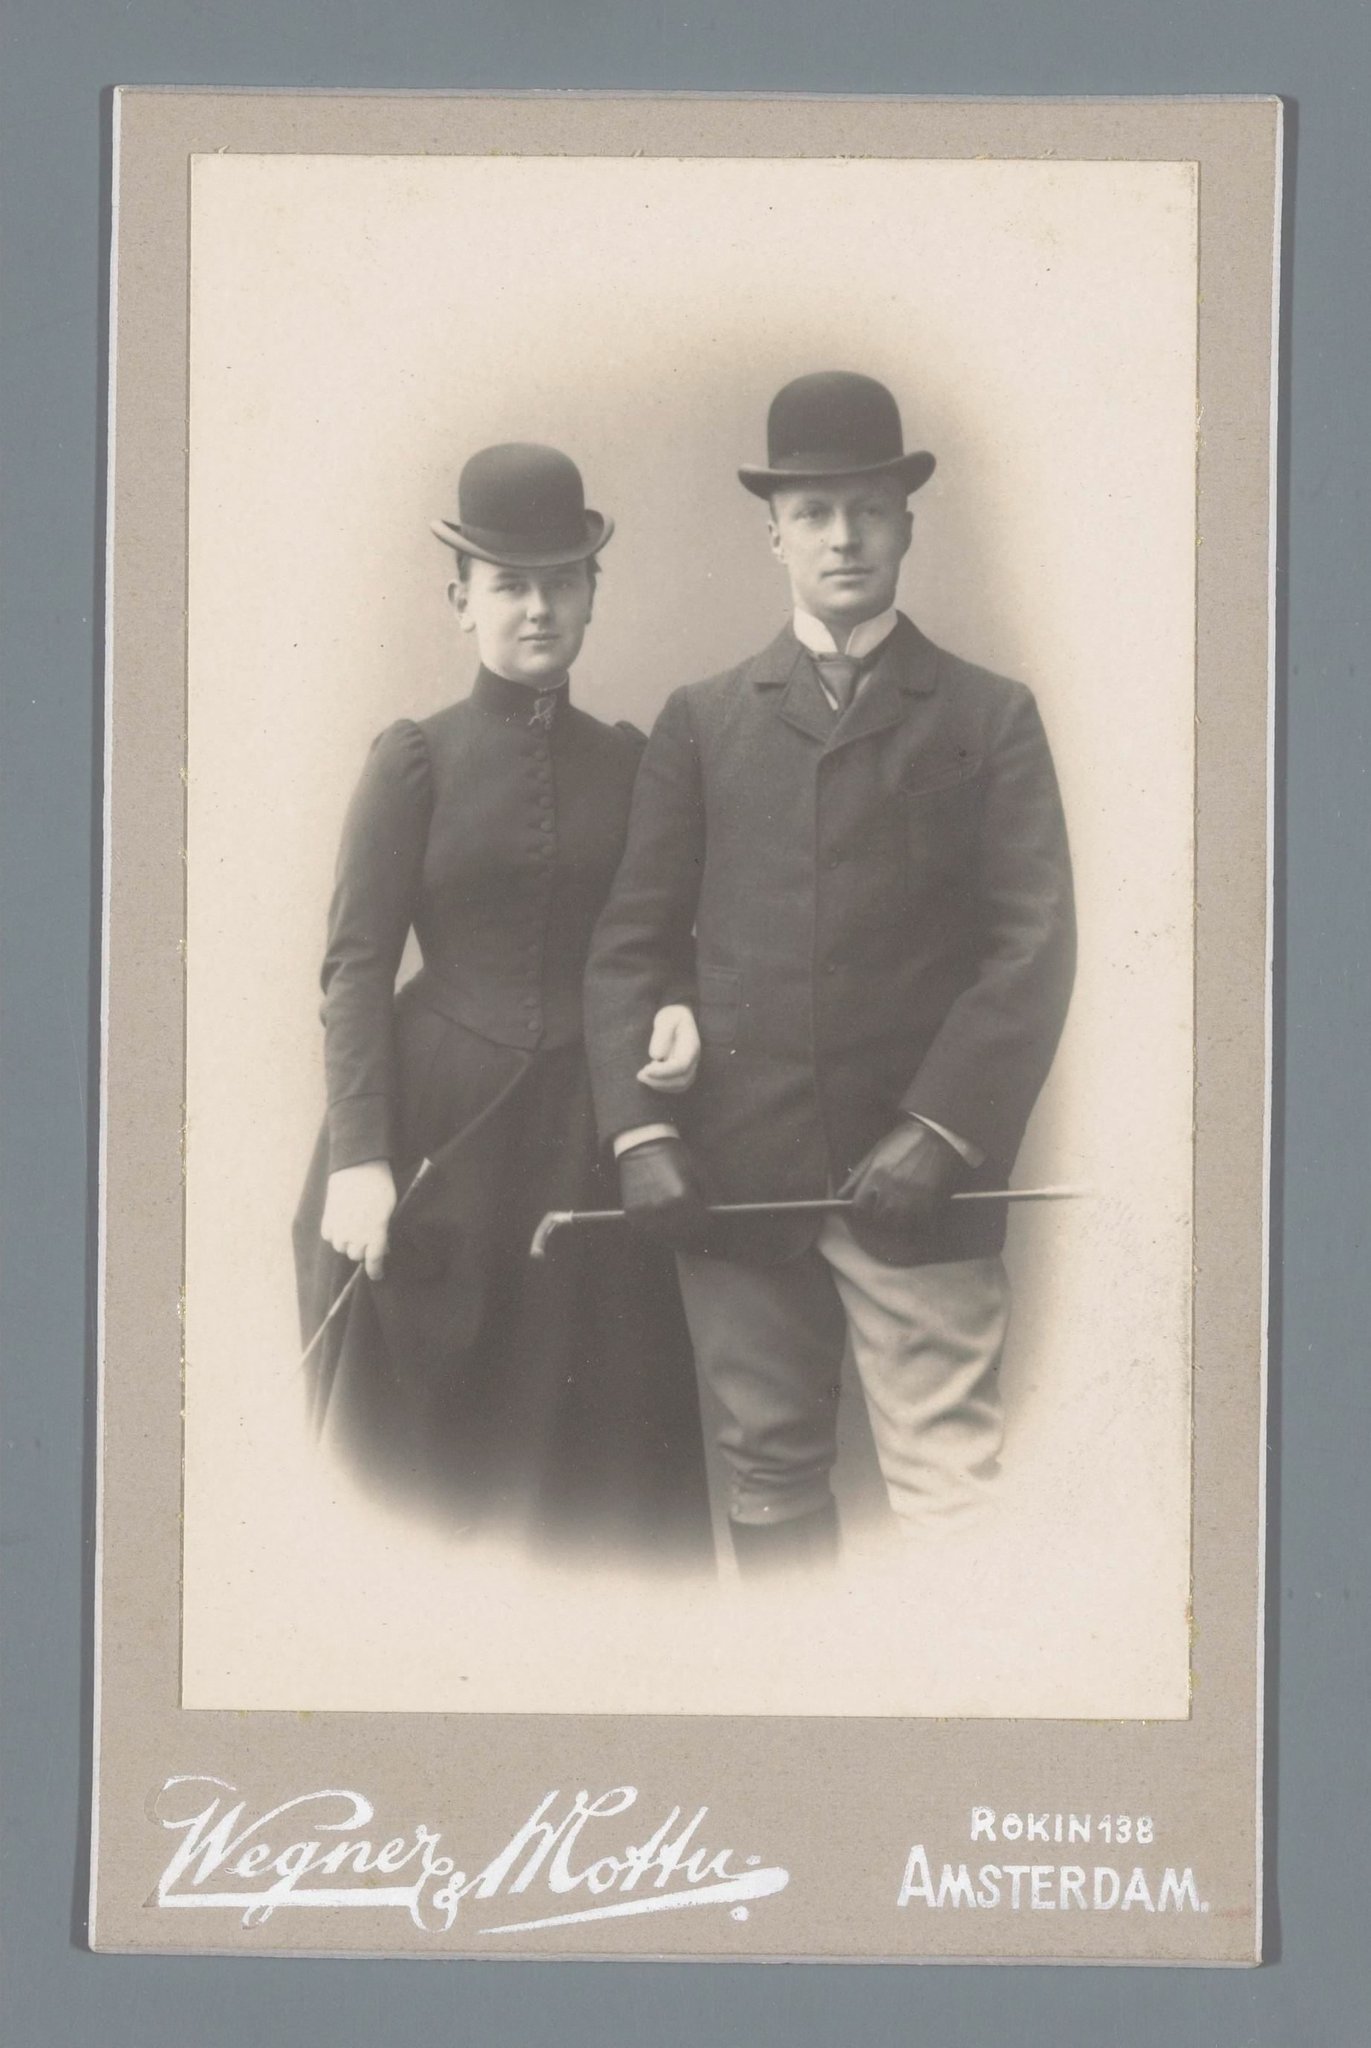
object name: photograph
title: Portret van koningin Wilhelmina en prins Hendrik in rijkleding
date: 1900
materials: cardboard, photographic support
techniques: gelatin silver print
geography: amsterdam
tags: the hague, print maker, wilhelmina of the netherlands, hendrik (prins der nederlanden (1876-1934)), riding a horse, ass, or mule; rider, horseman, prince, historical persons, queen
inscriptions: inscription: ‘1900’, address: ‘ROKIN 138/ AMSTERDAM’